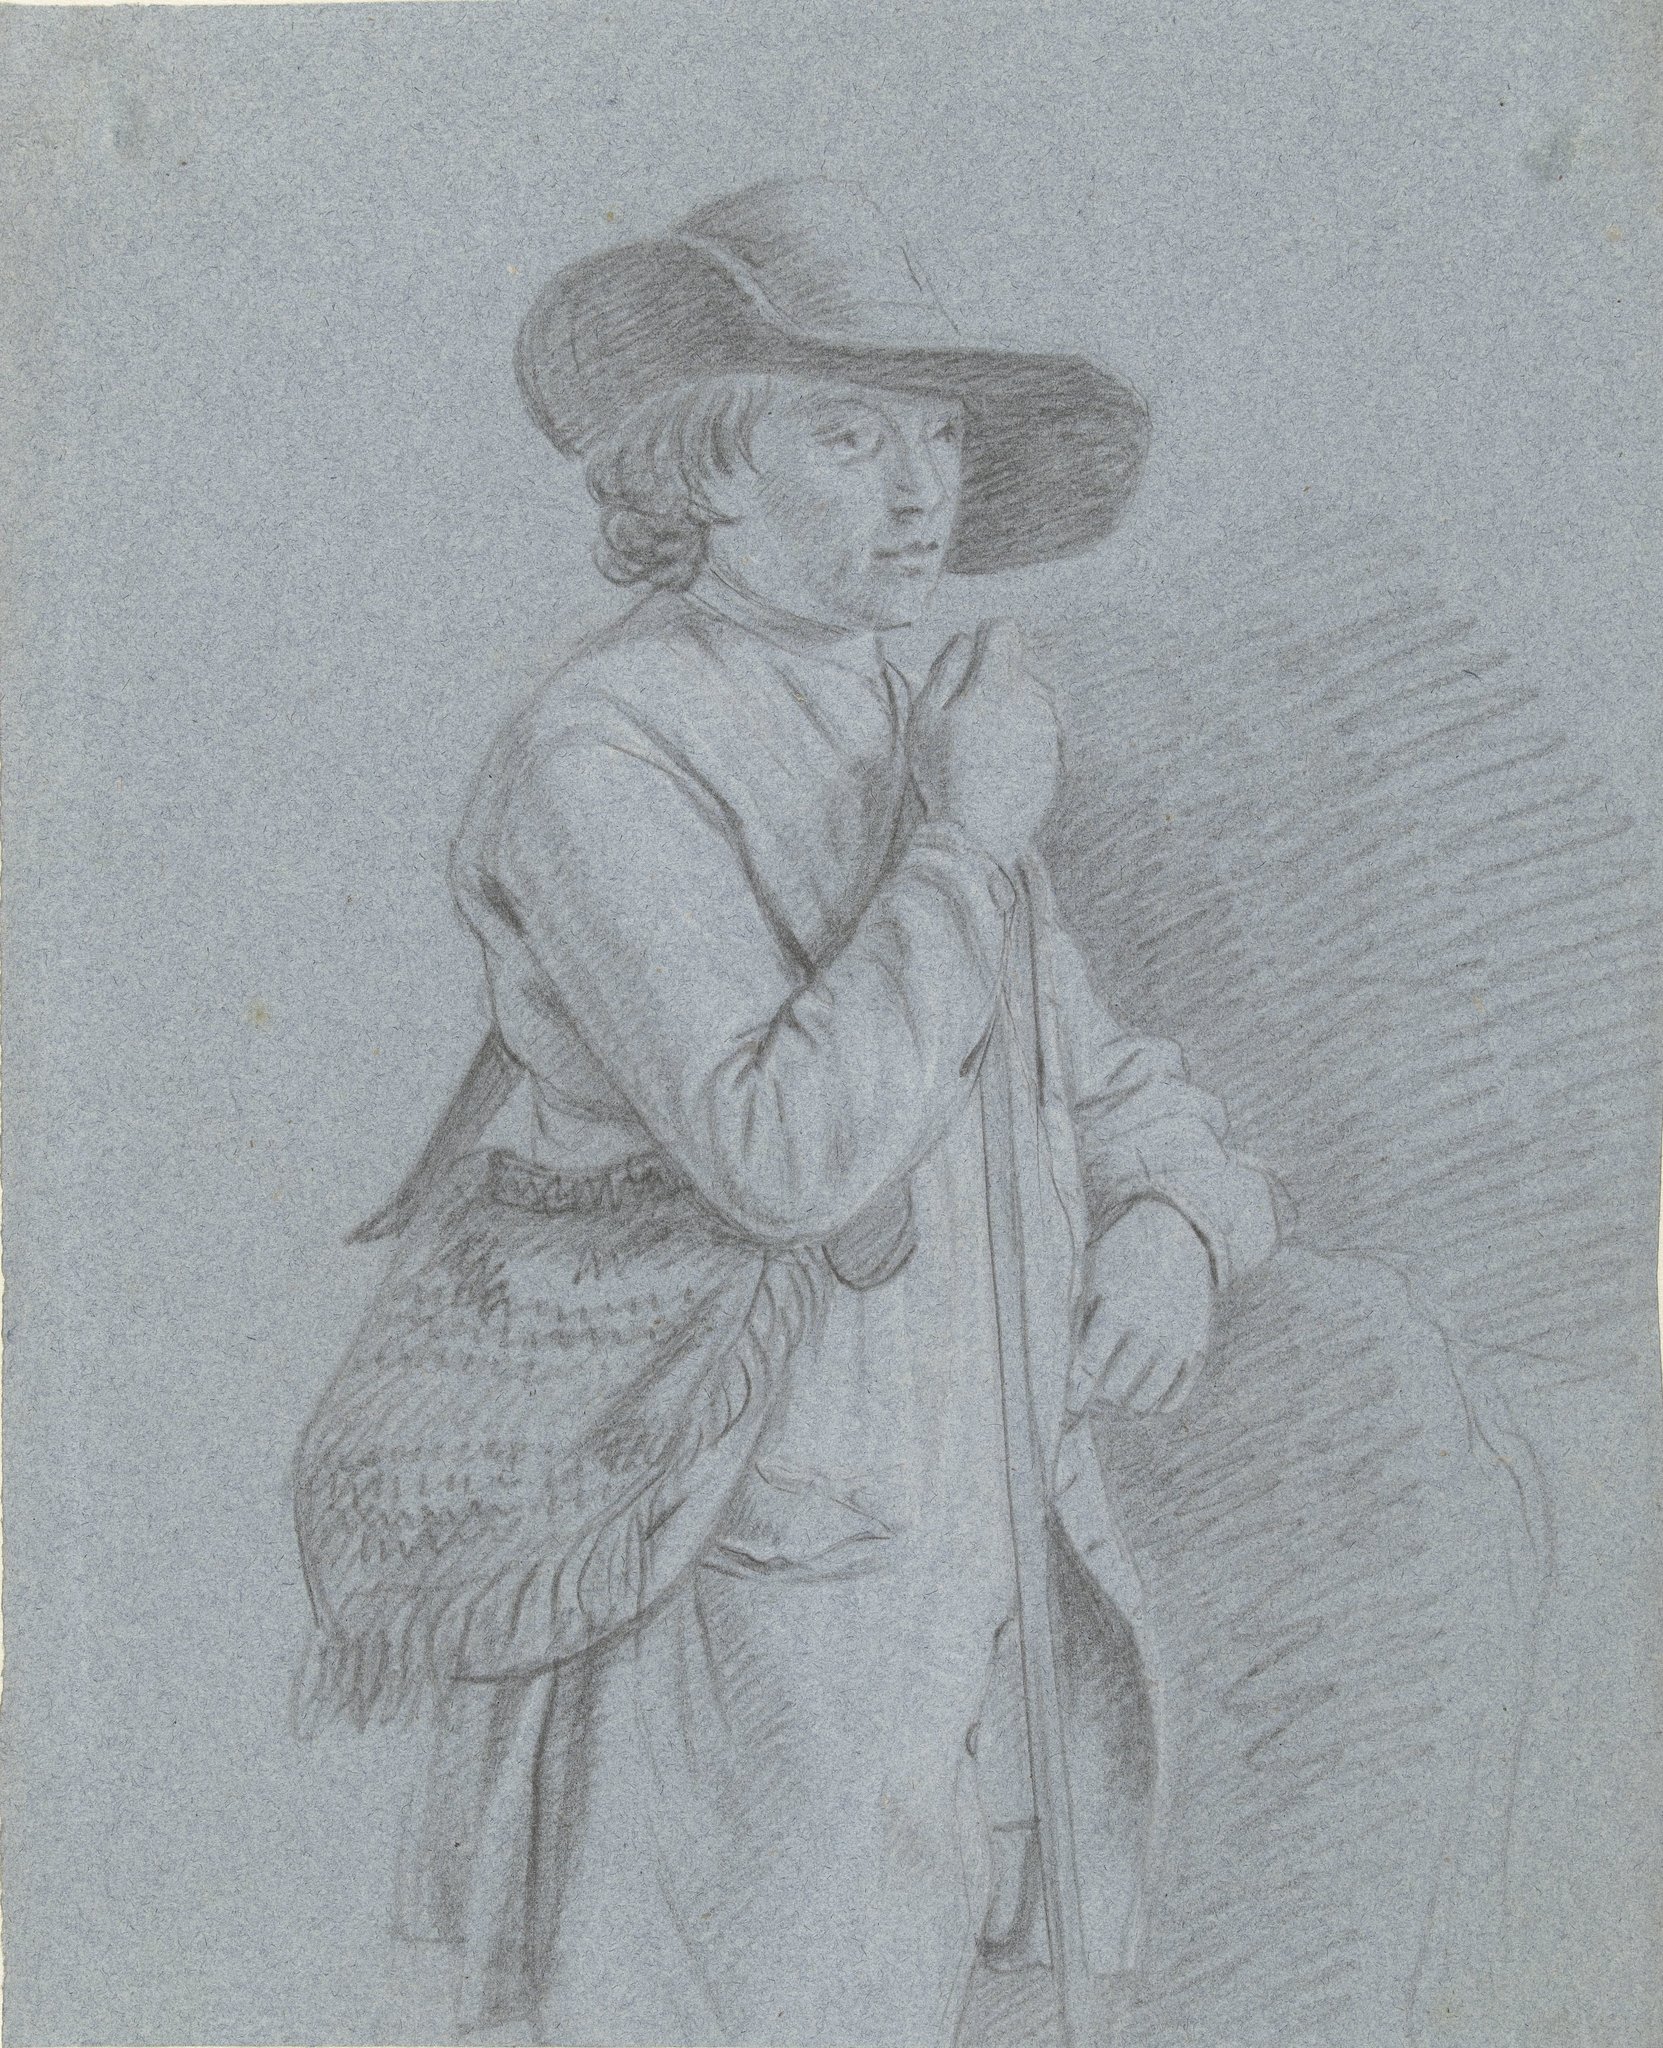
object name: drawing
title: Staande jager met weitas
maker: jordanus hoorn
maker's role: draughtsman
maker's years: 1753-1833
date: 1763-1833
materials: chalk, paper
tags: hunter